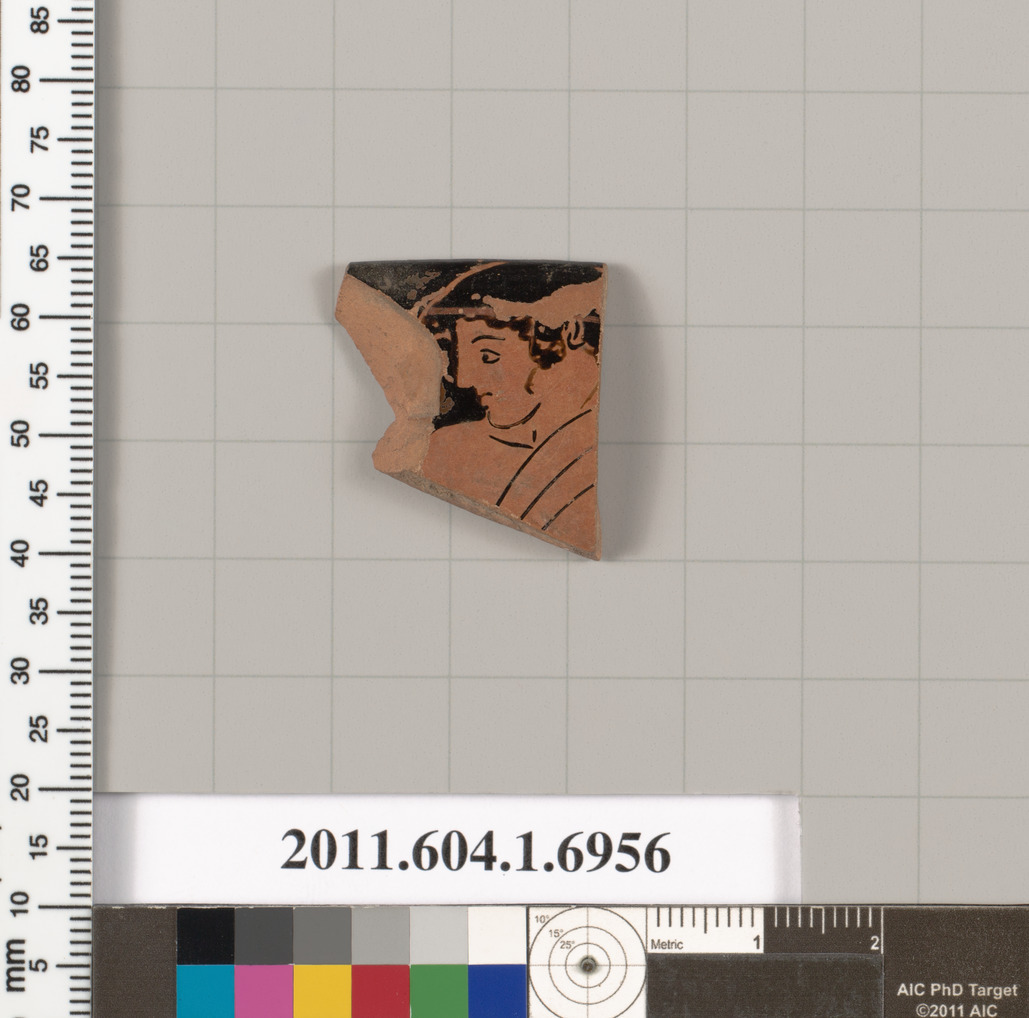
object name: kylix fragment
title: Terracotta rim fragment of a kylix (drinking cup)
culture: greek, attic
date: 490-470 BCE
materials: terracotta